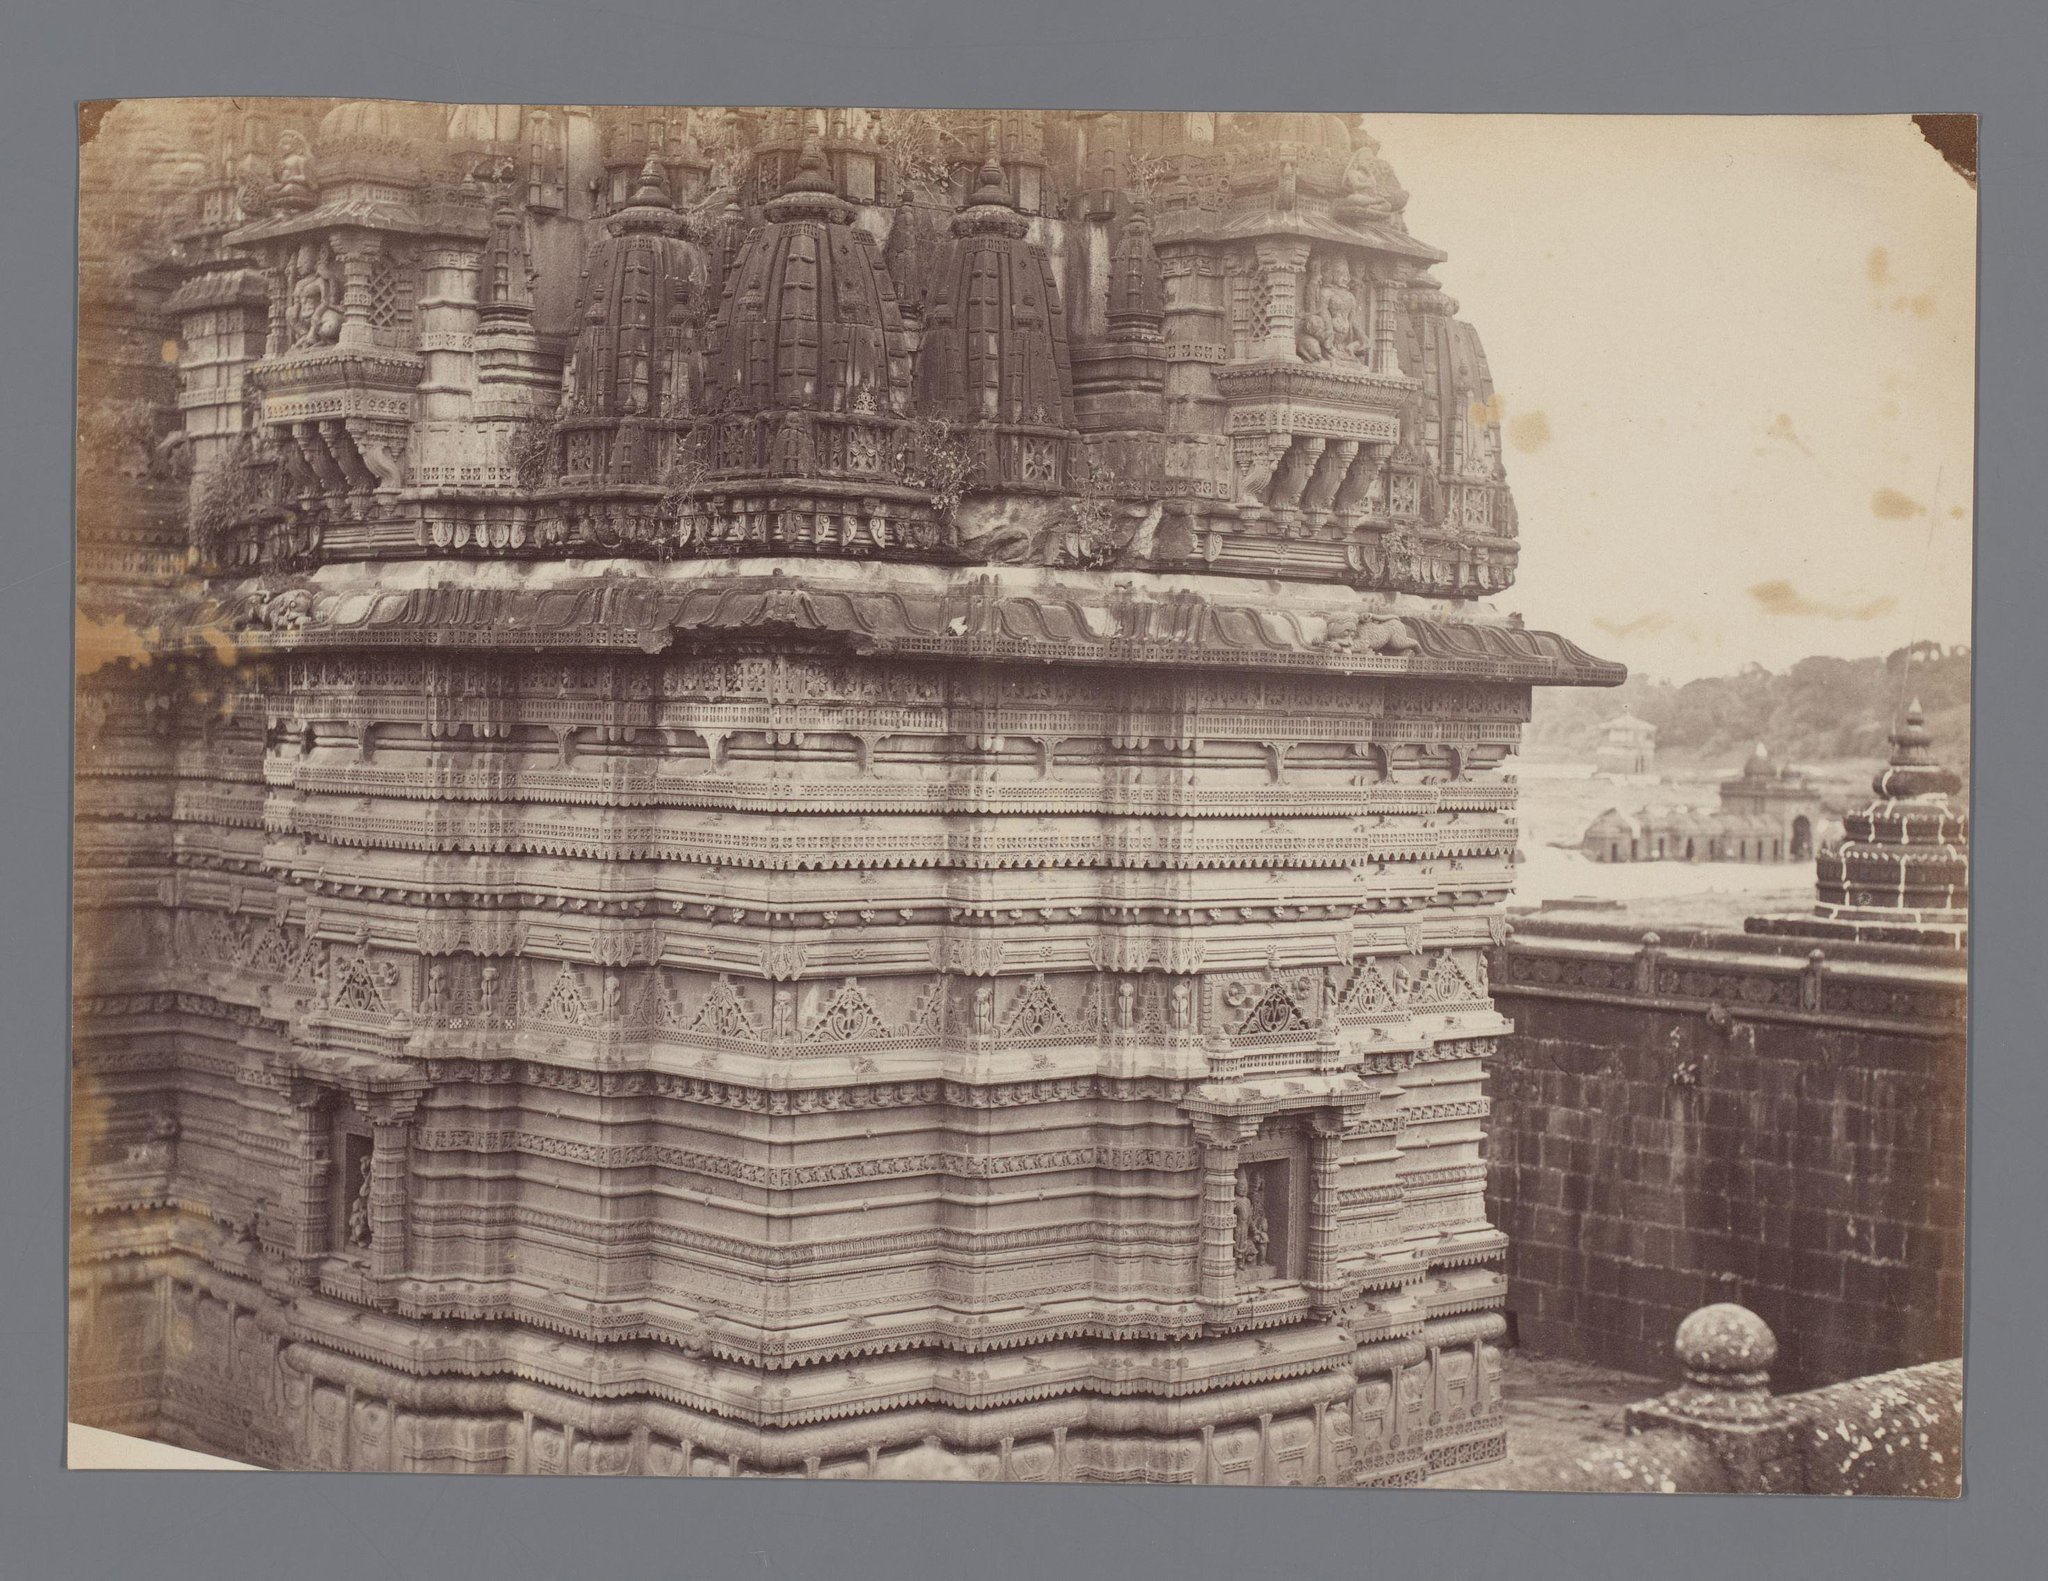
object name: photograph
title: Detail of a temple, India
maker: Anonymous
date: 1875-1900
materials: paper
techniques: albumen print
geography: india